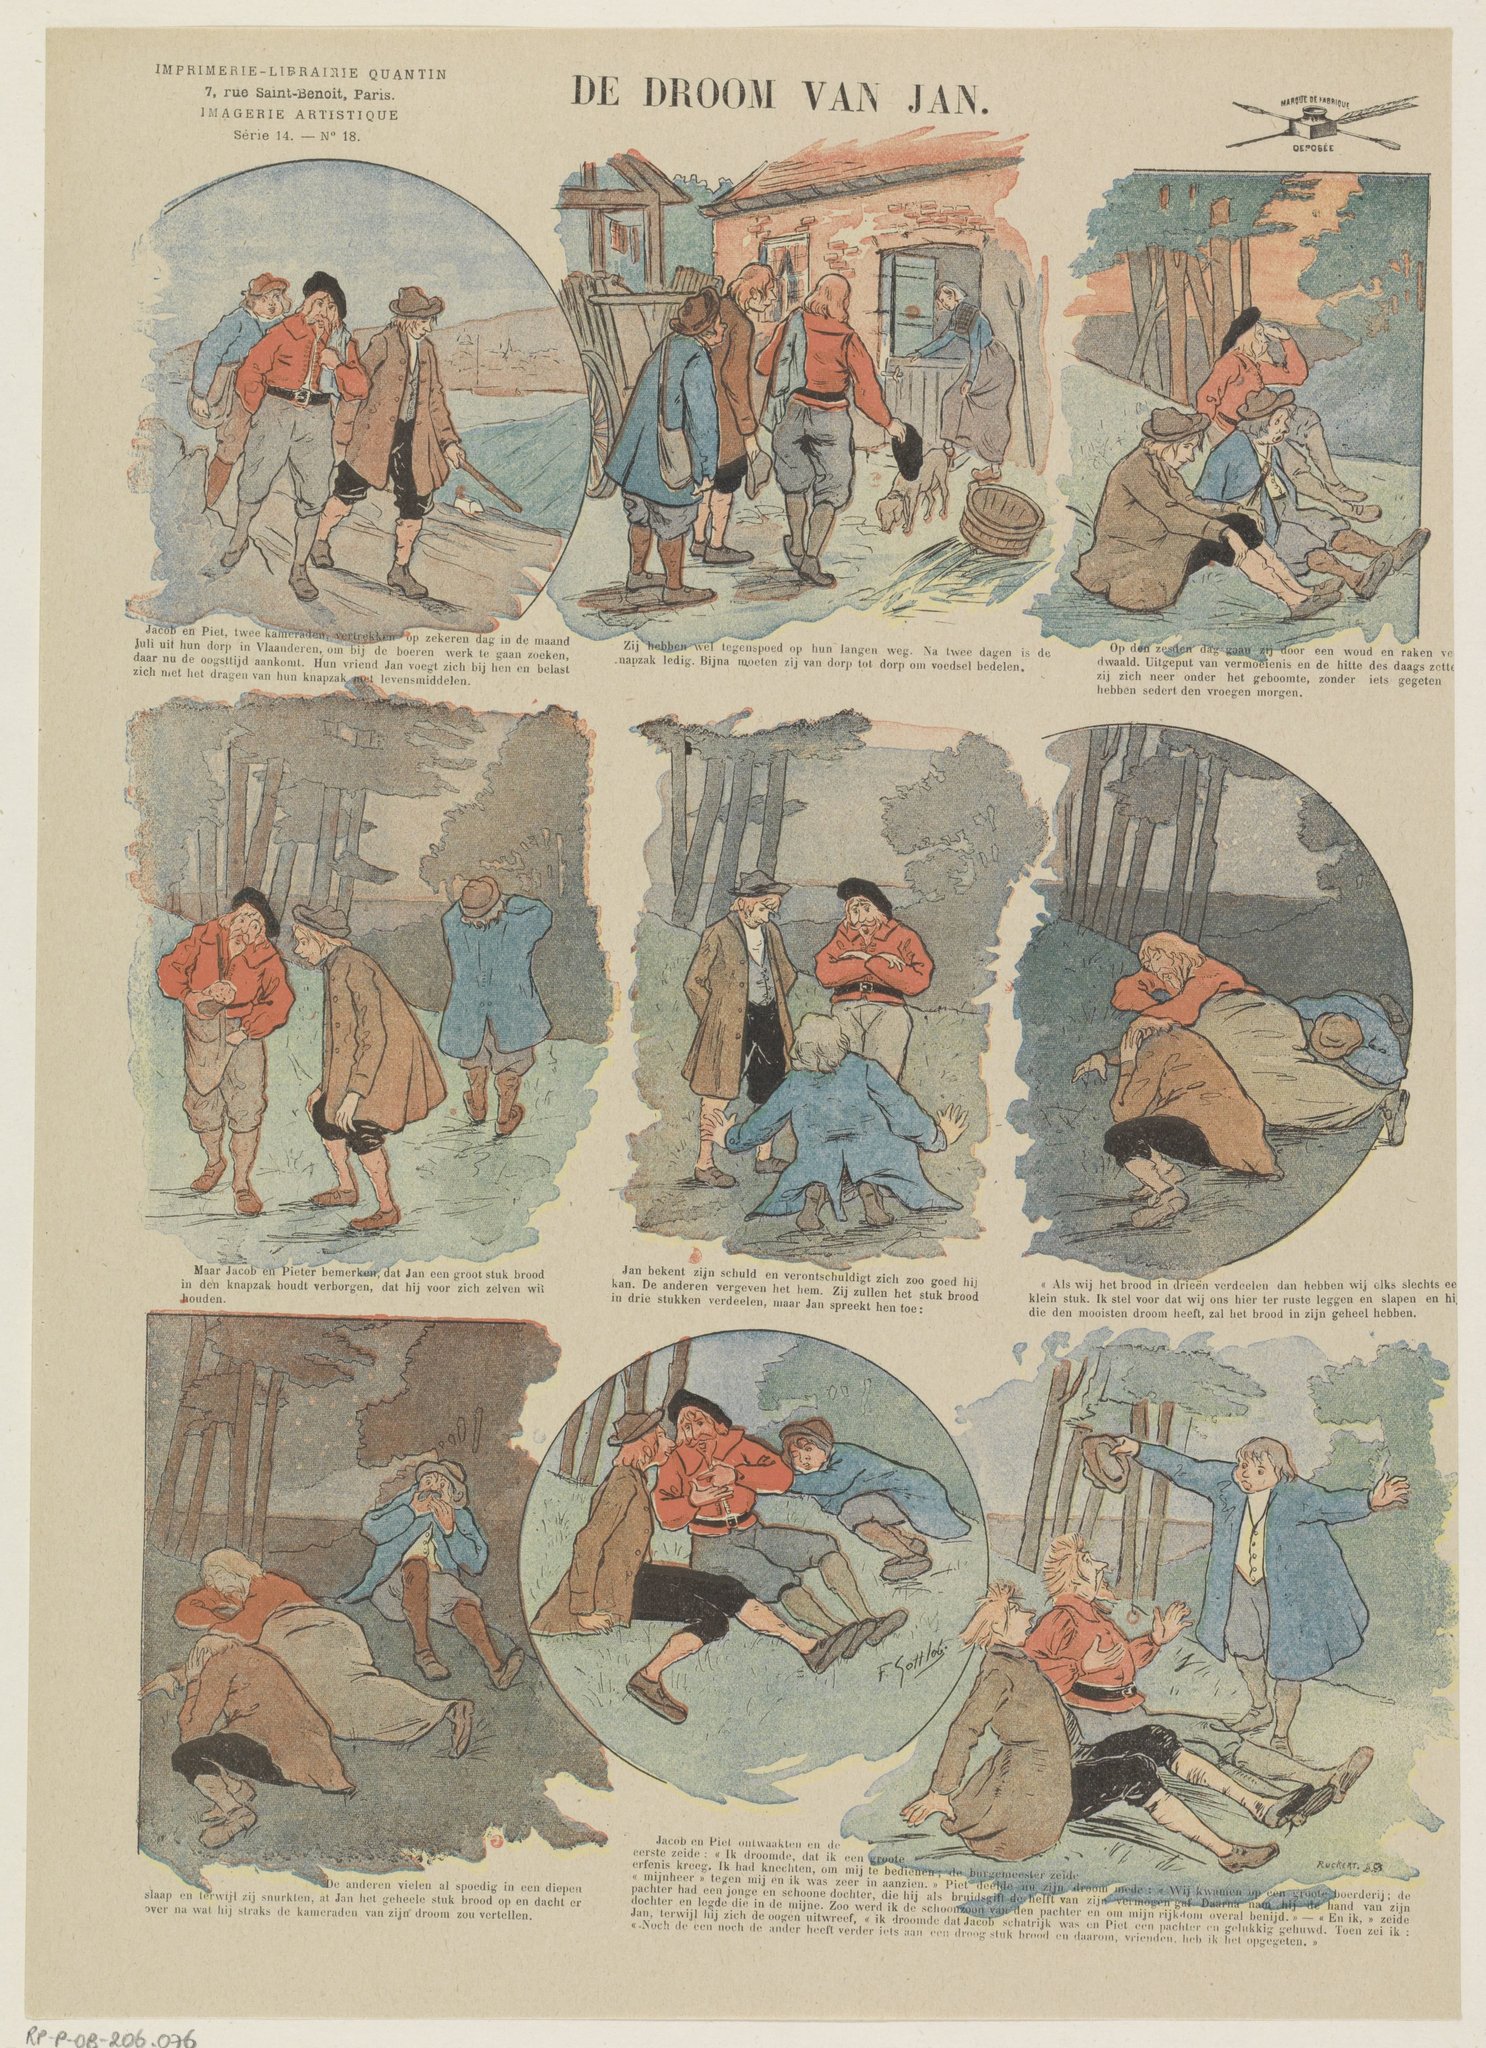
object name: popular print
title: De droom van Jan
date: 1876-1890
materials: paper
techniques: lithograph, letterpress printing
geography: paris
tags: going to sleep - bb - out of doors, bread, loaf, tales and fairy tales, departure ~ travelling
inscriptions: : ‘marque de fabrique / deposée’, collector's mark: Lugt 2760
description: Blad met 9 voorstellingen van drie vrienden die samen op reis gaan. Jan eet het laatste stuk brood op. Onder elke afbeelding een onderschrift. Genummerd linksboven: Série 14. - No. 18.